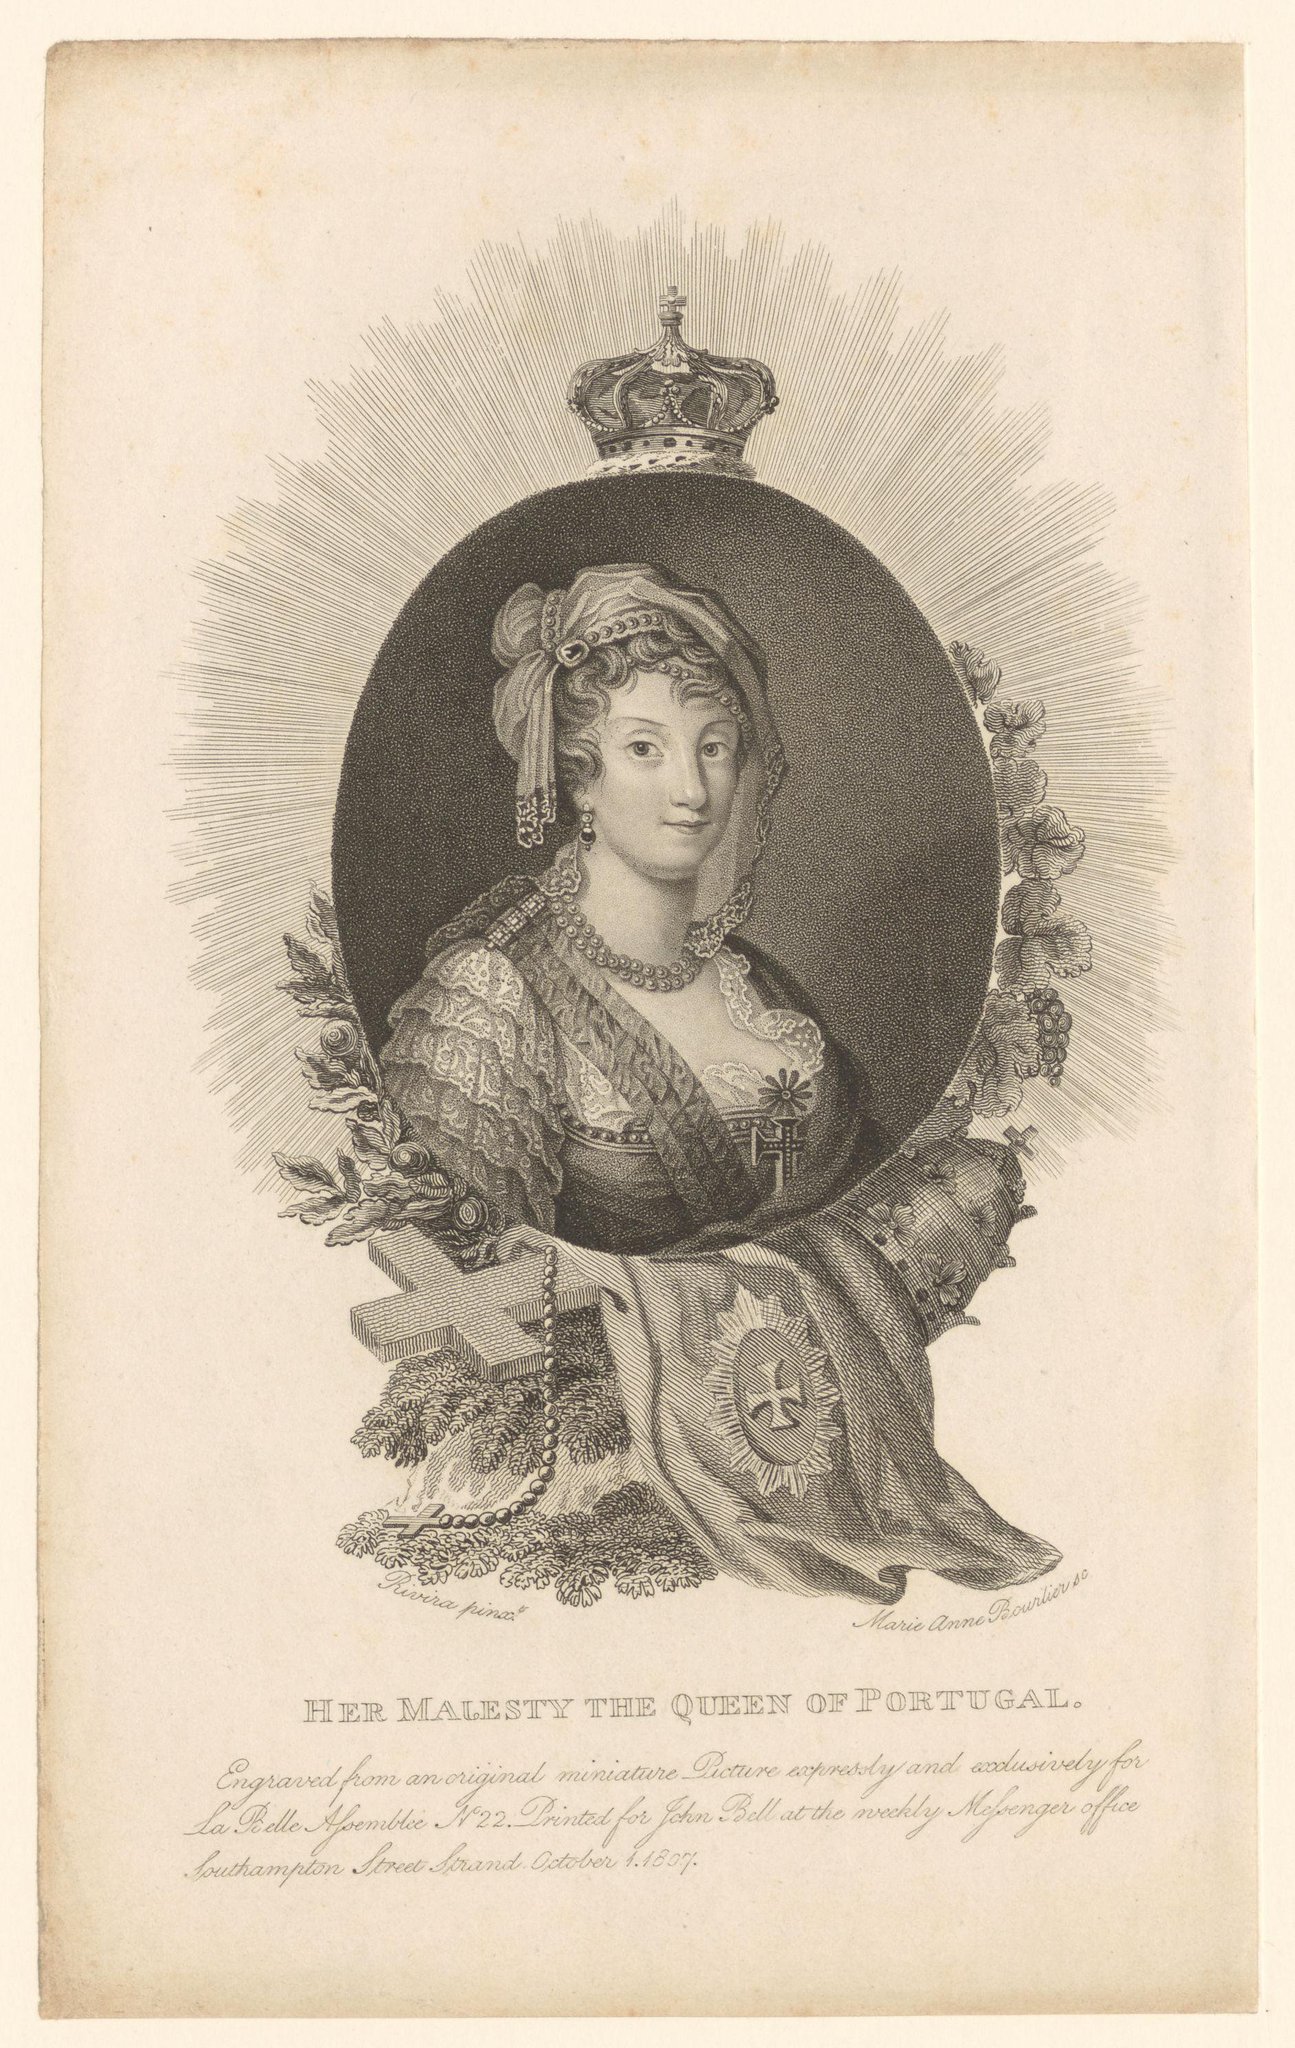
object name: print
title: Portret van Maria I van Portugal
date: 1807-1810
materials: paper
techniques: etching, engraving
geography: london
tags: maria i van portugal, historical persons, queen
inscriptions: collector's mark: Lugt 2228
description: Prent uit: La Belle Assemblée (...), vol. 22, 1807.